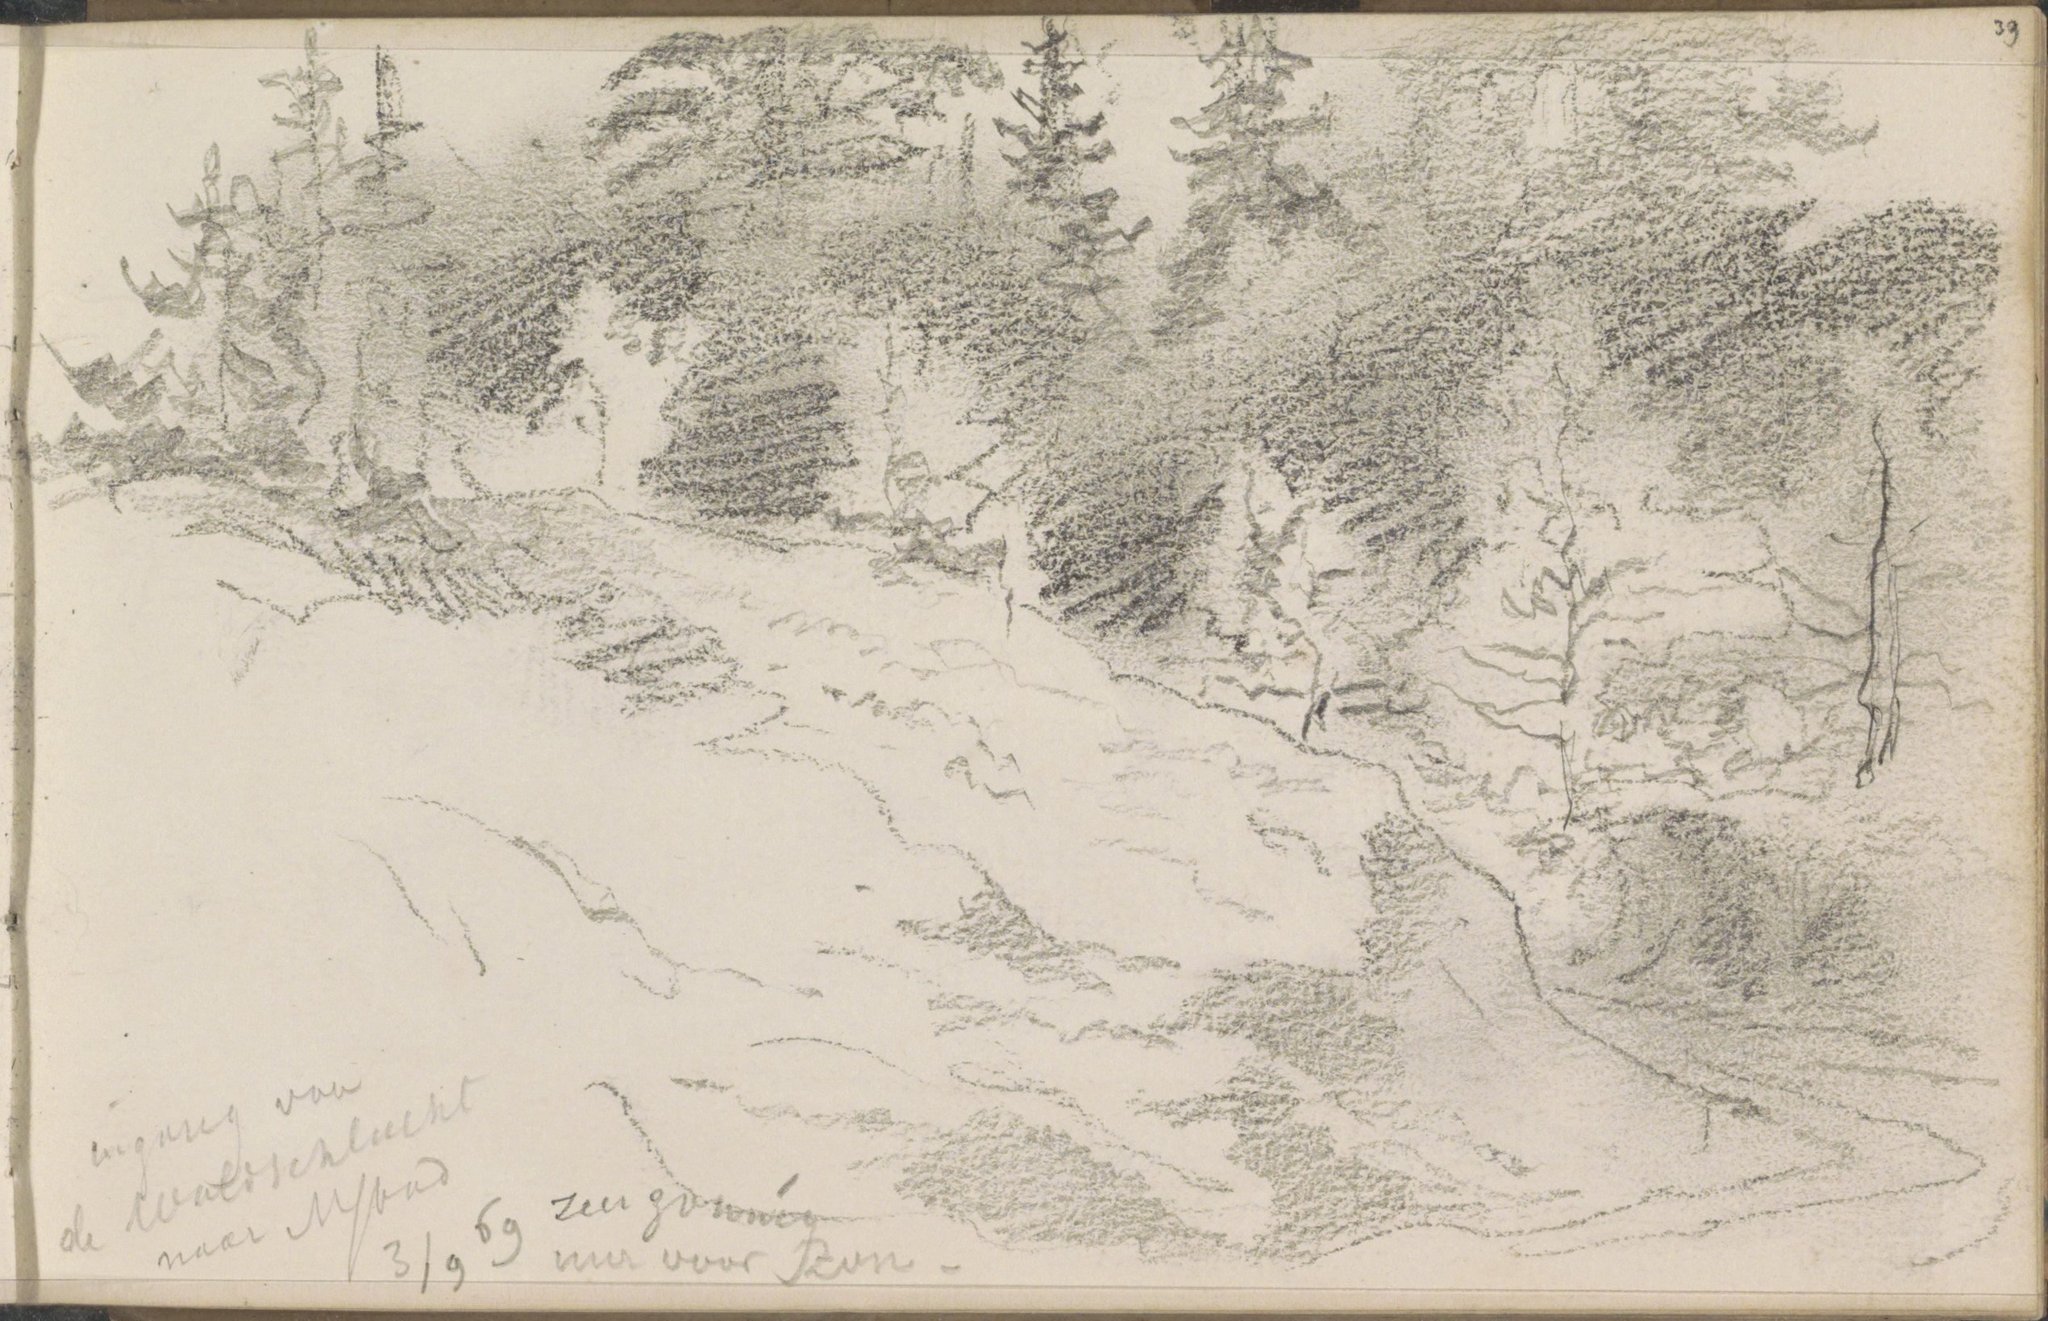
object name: sketchbook leaf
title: Ingang van het dal dat naar Marienbad leidt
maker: johannes tavenraat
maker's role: draughtsman, painter, print maker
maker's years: 1809-1881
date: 1809-1869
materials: paper, pencil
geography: marienbad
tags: dale, valley, marienbad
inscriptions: date and inscription: ‘ingang van/ de waldschlucht naar M/bad/ 3/9 69’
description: Blad 39 recto uit een schetsboek met 48 bladen.